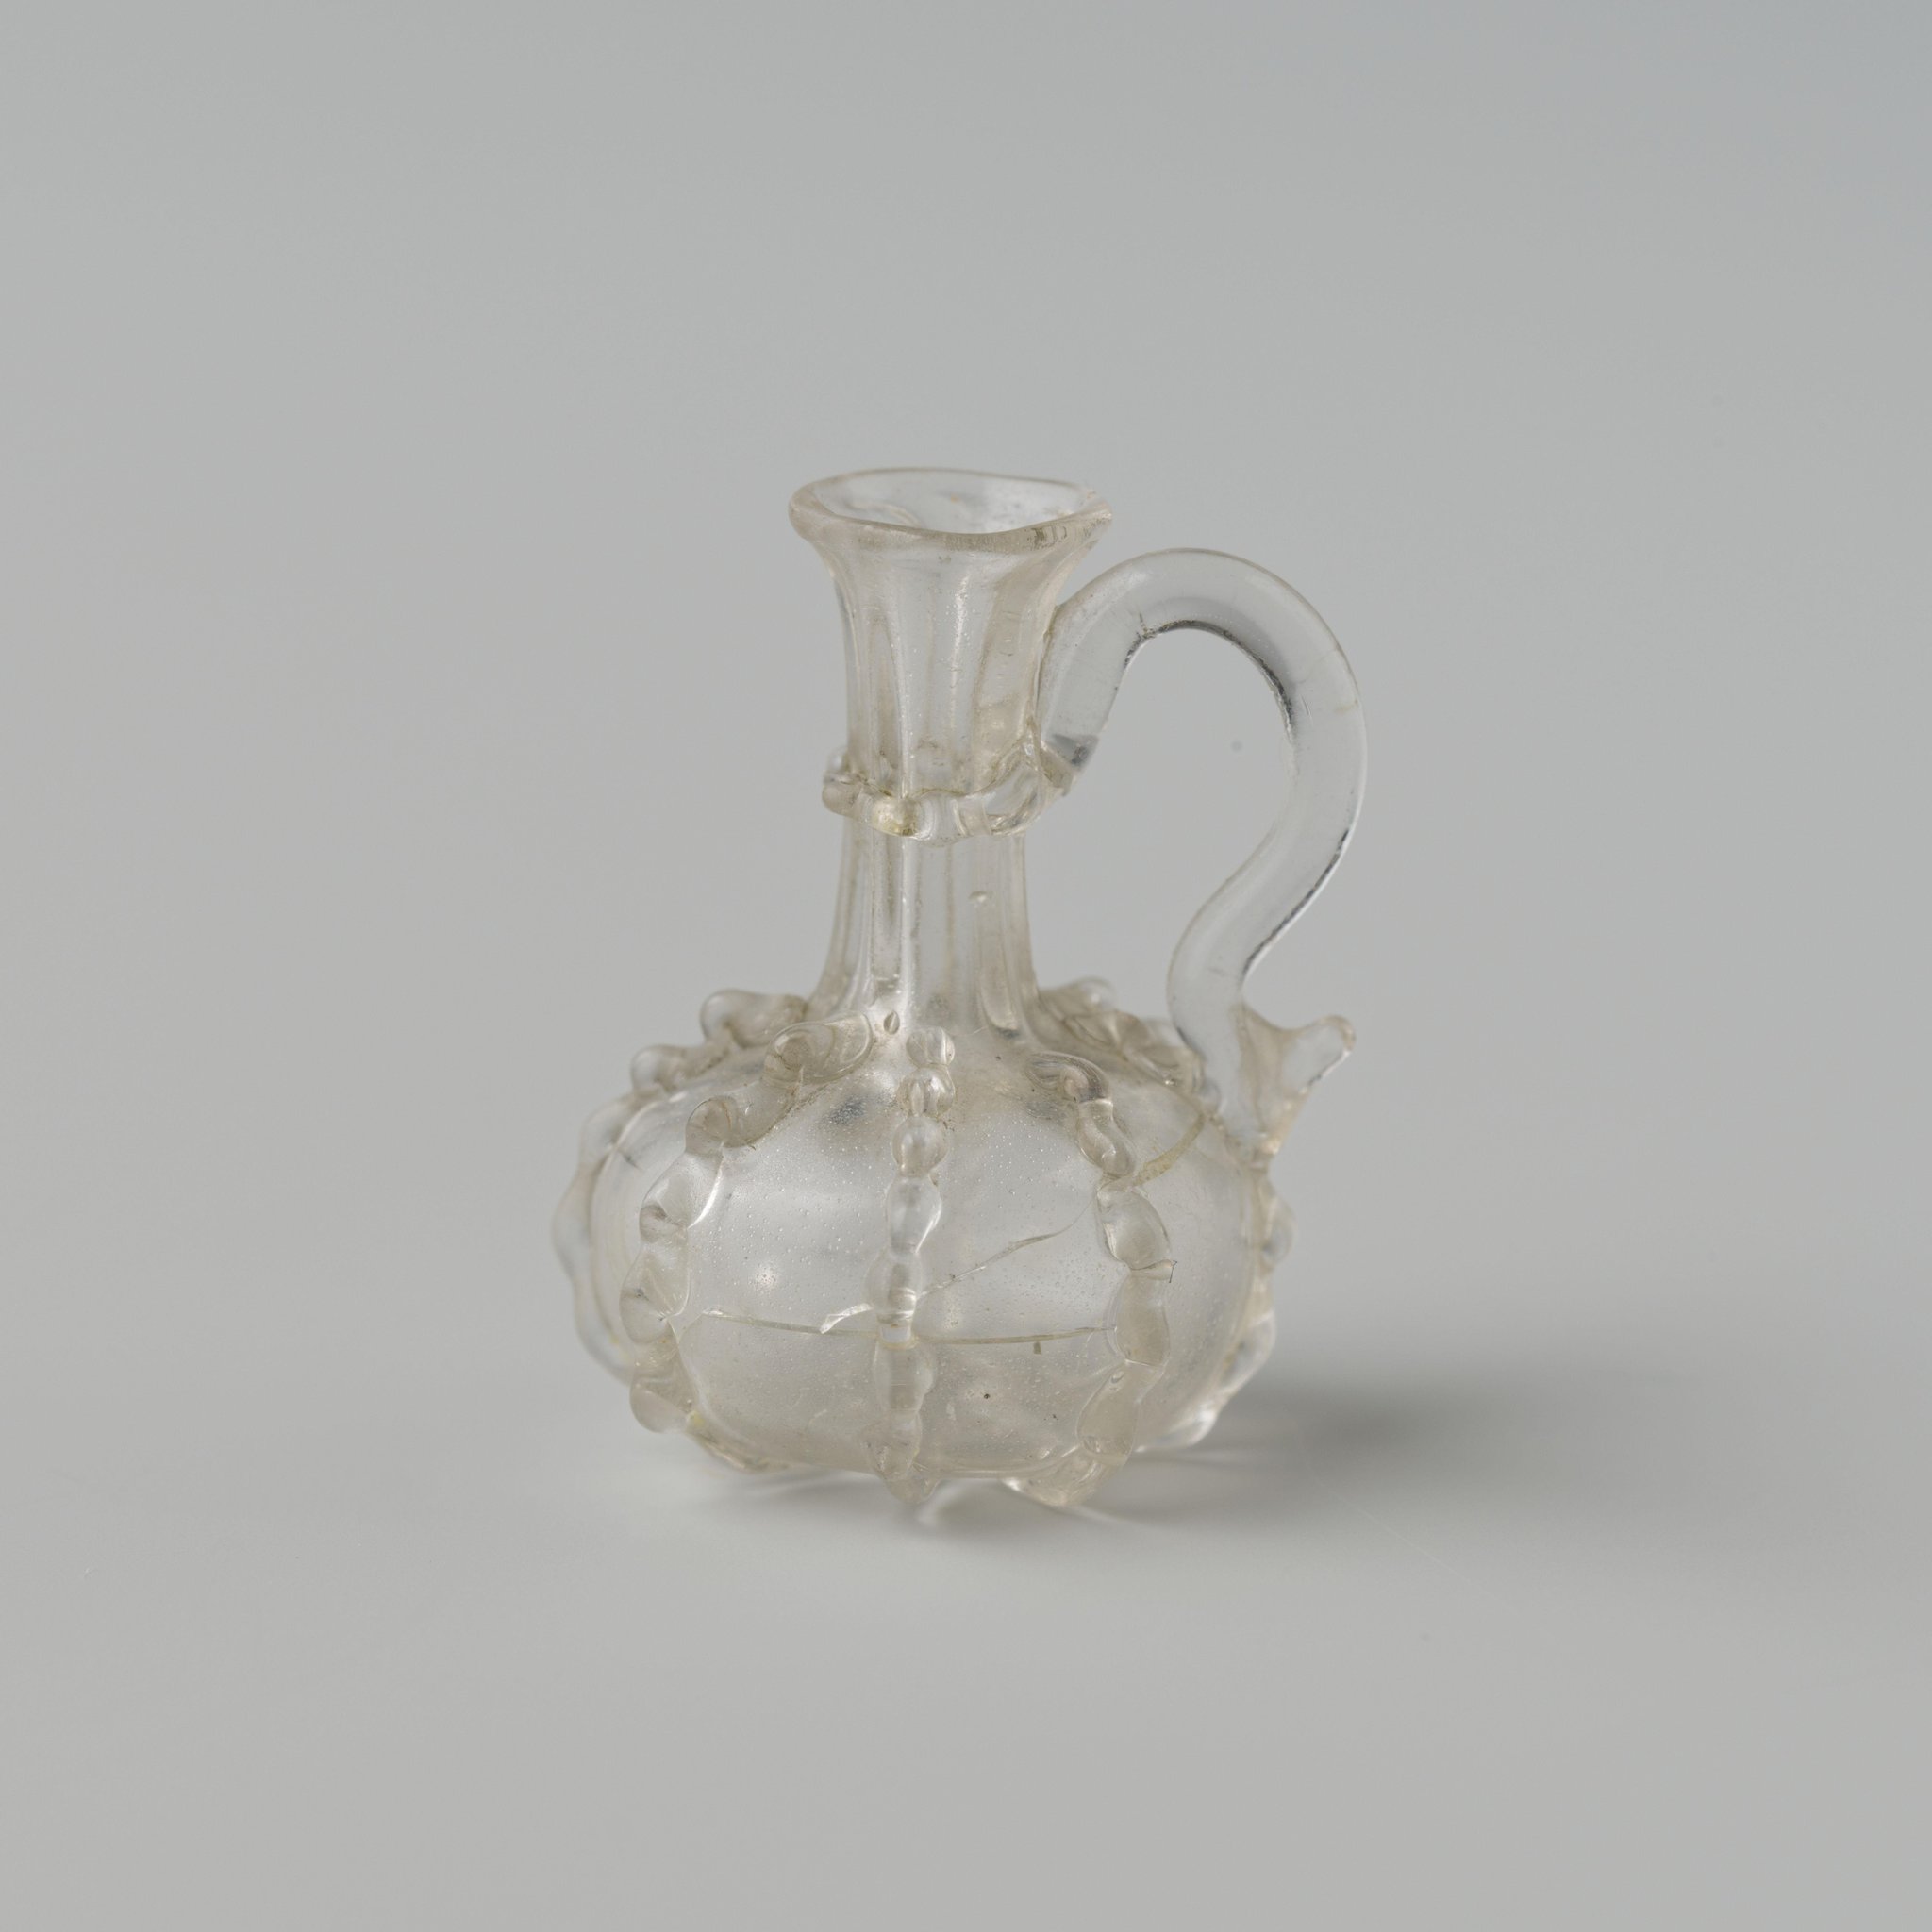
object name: carafe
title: Kan van helder kleurloos glas, bolvormig lichaam versierd met acht geknepen verticale opgelegde ribbels en licht ingestoken ziel.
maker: Anonymous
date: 1675-1710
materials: glass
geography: amsterdam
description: Eén van twee kannen van helder kleurloos glas, bolvormig lichaam versierd met acht geknepen verticale opgelegde ribbels en licht ingestoken ziel; hoge slanke hals met gladde ribbels en geknepen druipring. S-vormig handvat.